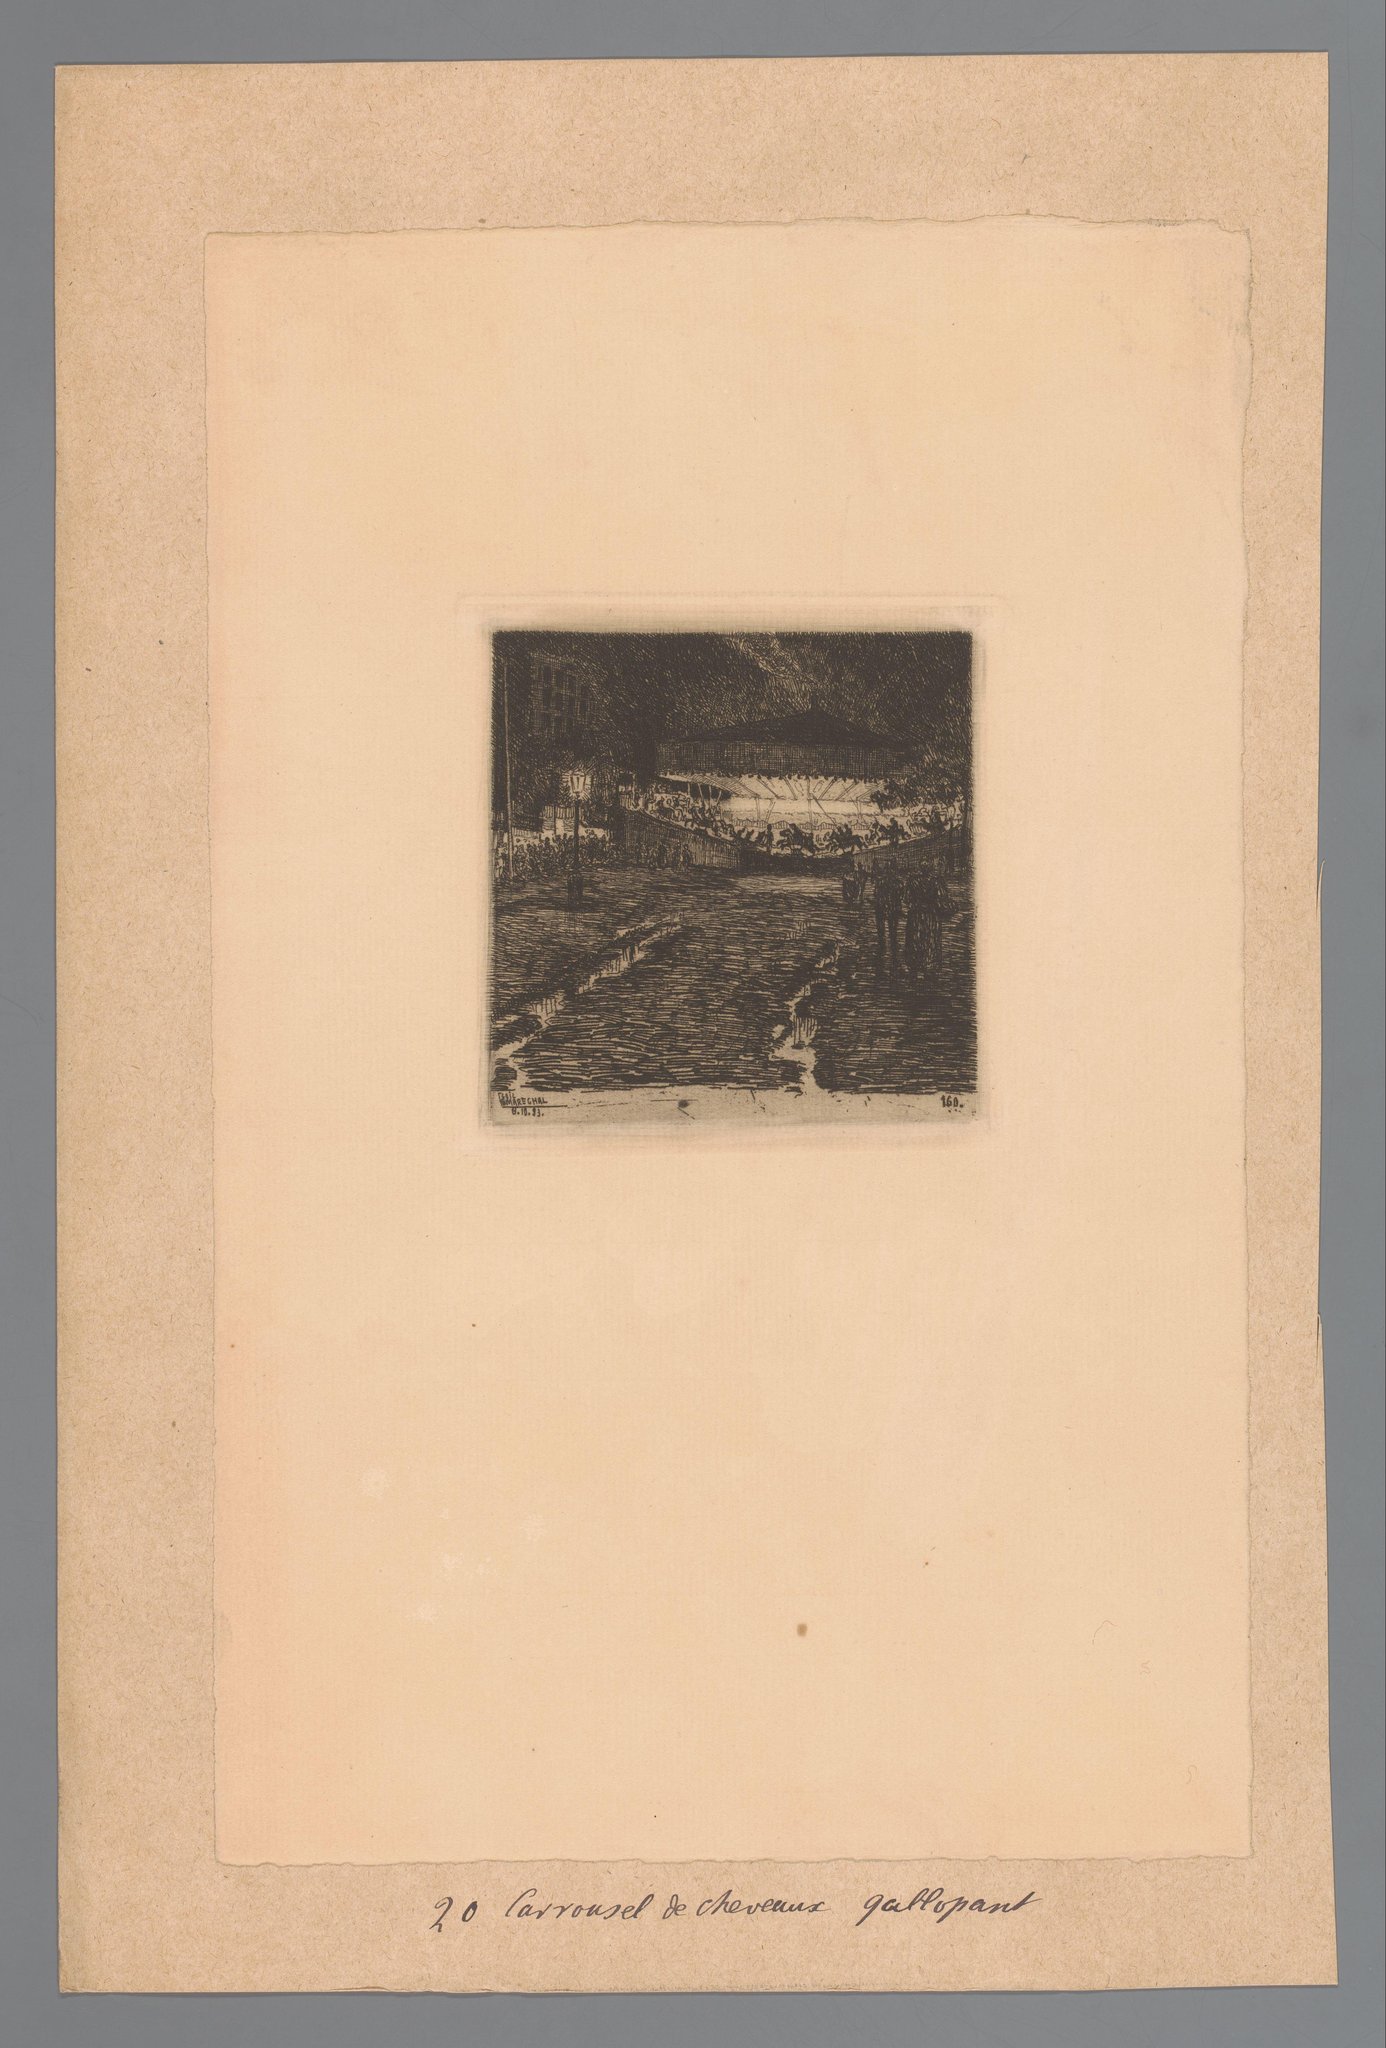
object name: print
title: Draaimolen bij avond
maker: françois maréchal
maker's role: print maker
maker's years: 1861-1945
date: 1893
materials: paper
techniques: etching, intaglio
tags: pleasure fair and circus, carrousel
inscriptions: collector's mark: Lugt 2228